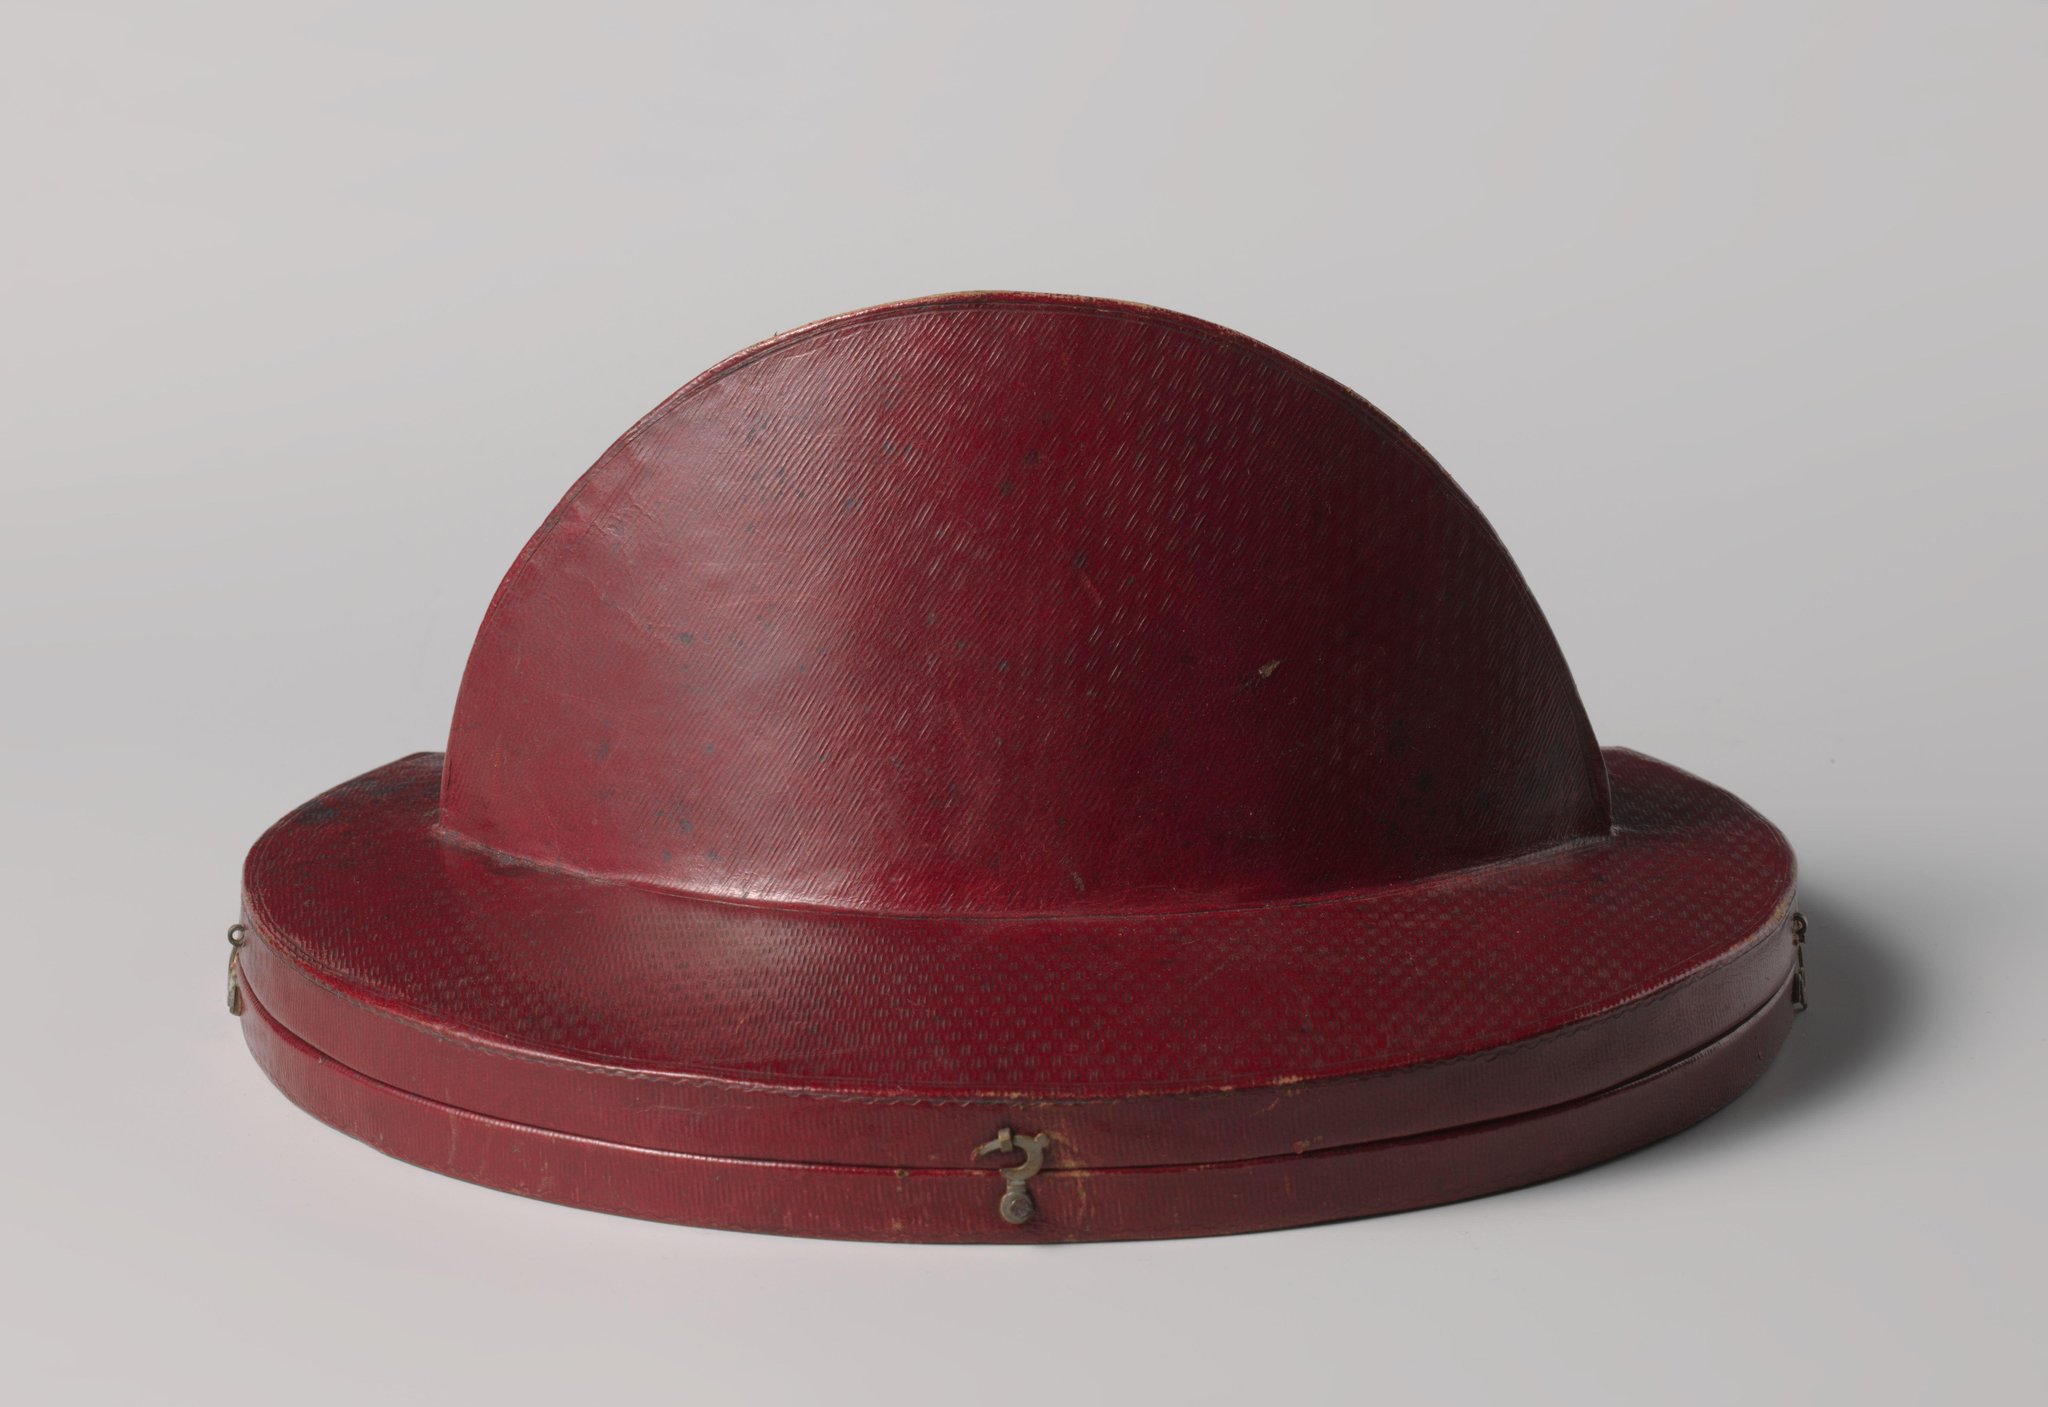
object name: case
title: Foedraal van rood leer, met voering van witte zijde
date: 1835-1837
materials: leather, silk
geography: amsterdam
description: Foedraal van rood leer, met voering van witte zijde. Het foedraal behoord bij een parure.